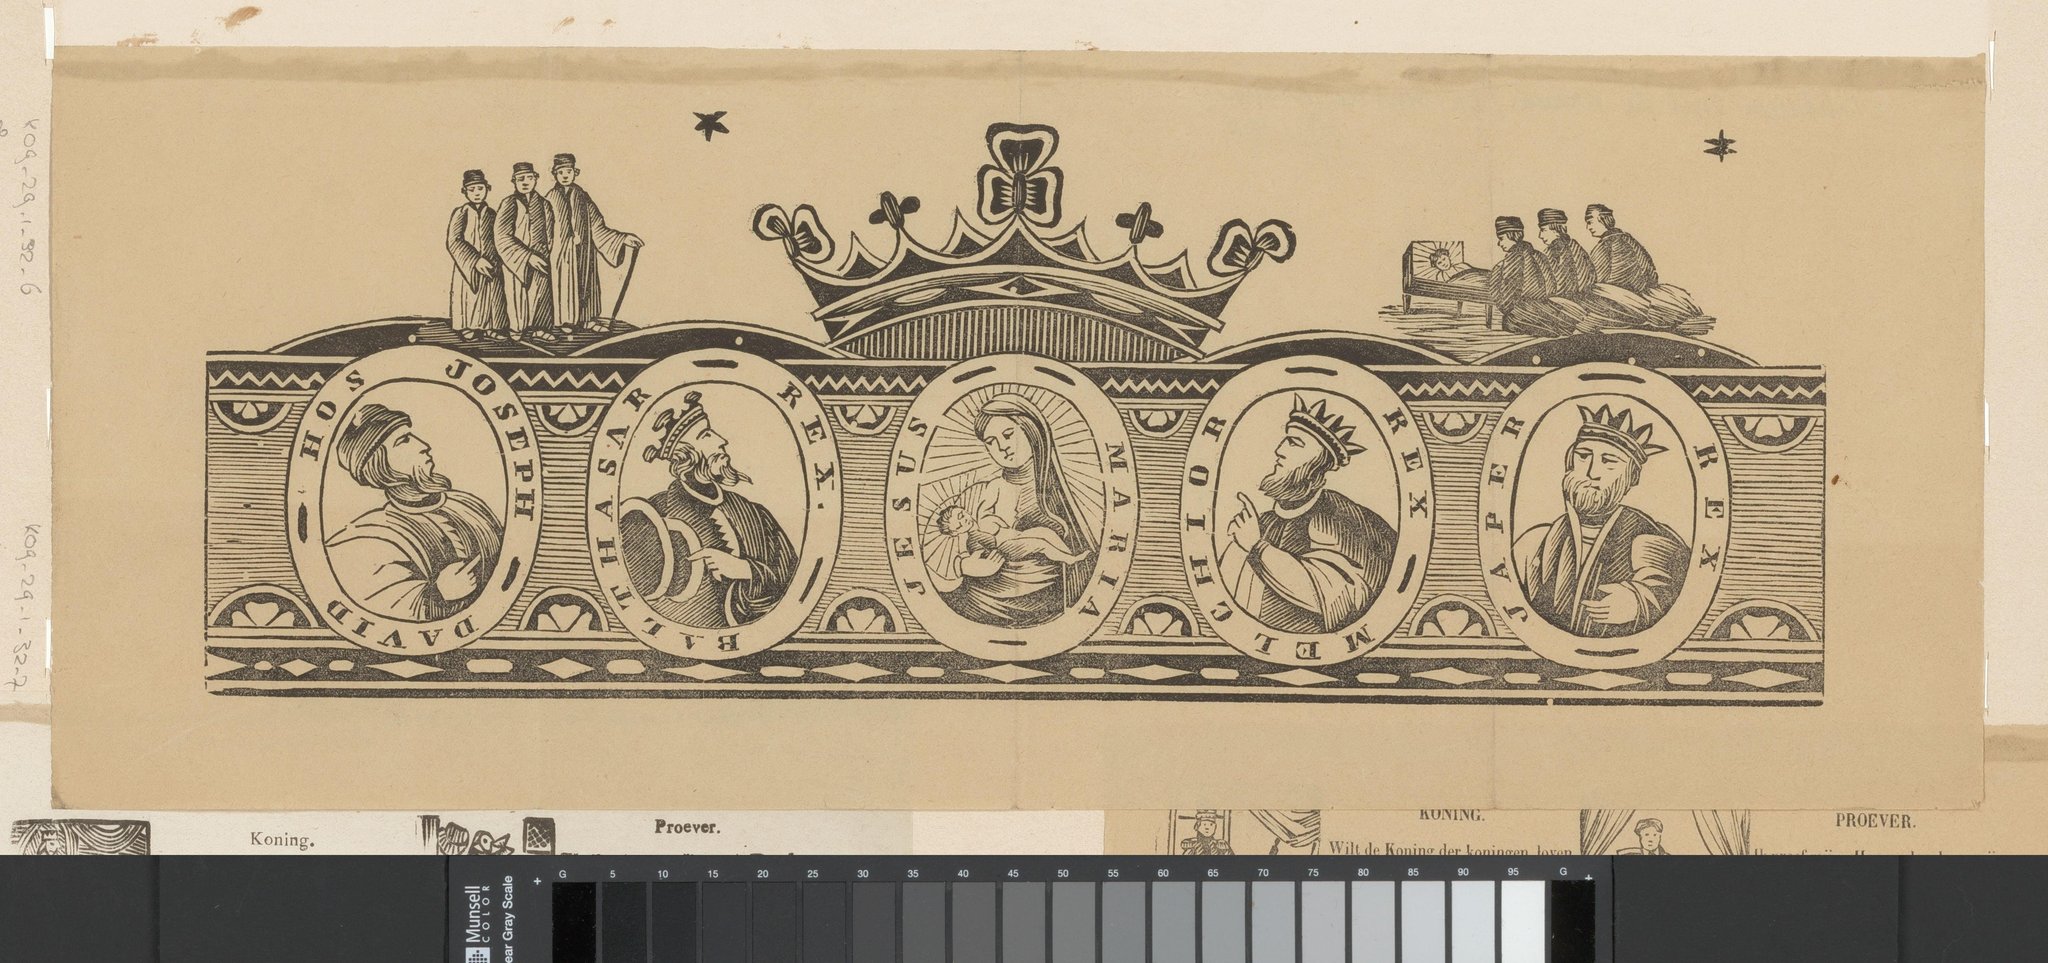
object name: print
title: Driekoningenkroon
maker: Anonymous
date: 1850-1915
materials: paper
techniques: woodcut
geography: netherlands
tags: the story of the three wise men (kings or magi) (matthew 2:1-12), epiphany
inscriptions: collector's mark, collector's mark: Lugt 1641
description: Driekoningenkroon. Kroon waarop afbeeldingen van Jozef, Balthasar, Maria met kind, Melchior en Casper. Boven twee scènes uit het verhaal van de drie wijzen, een kroon en twee sterren. Om uit te knippen. Onderwerpsrubrieken binnen de Atlas Zeden en Gewoonten: Volksfeesten; Driekoningen.